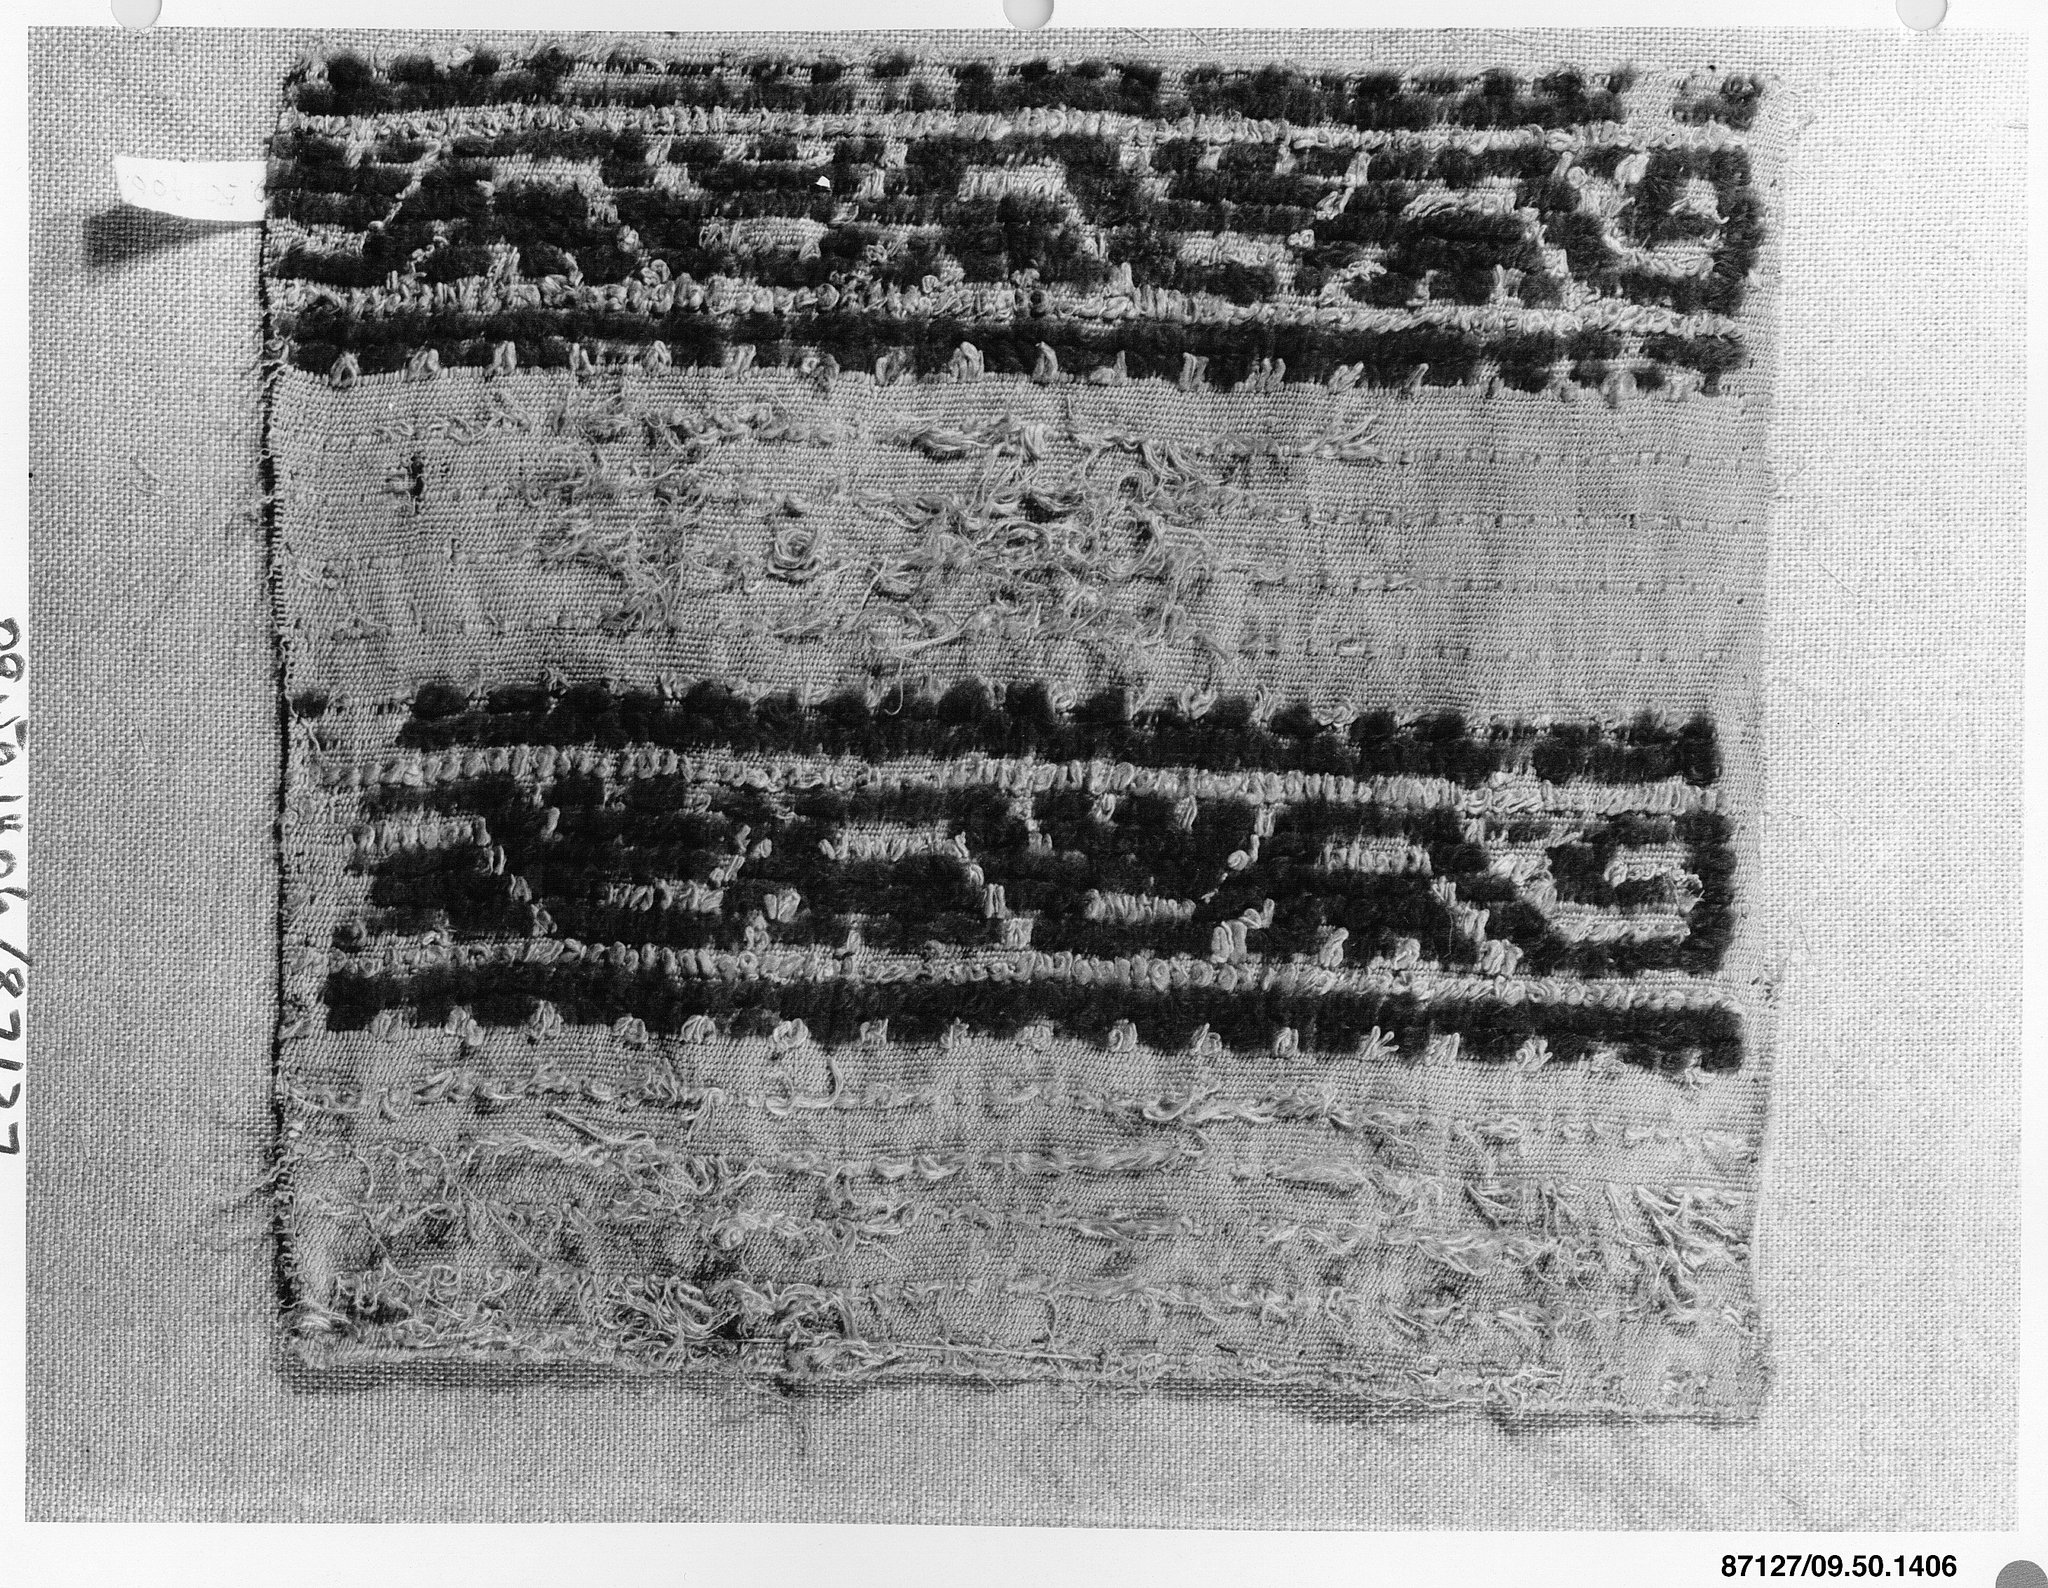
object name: textile fragment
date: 201-400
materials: linen, wool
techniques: embroidery, weave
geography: egypt